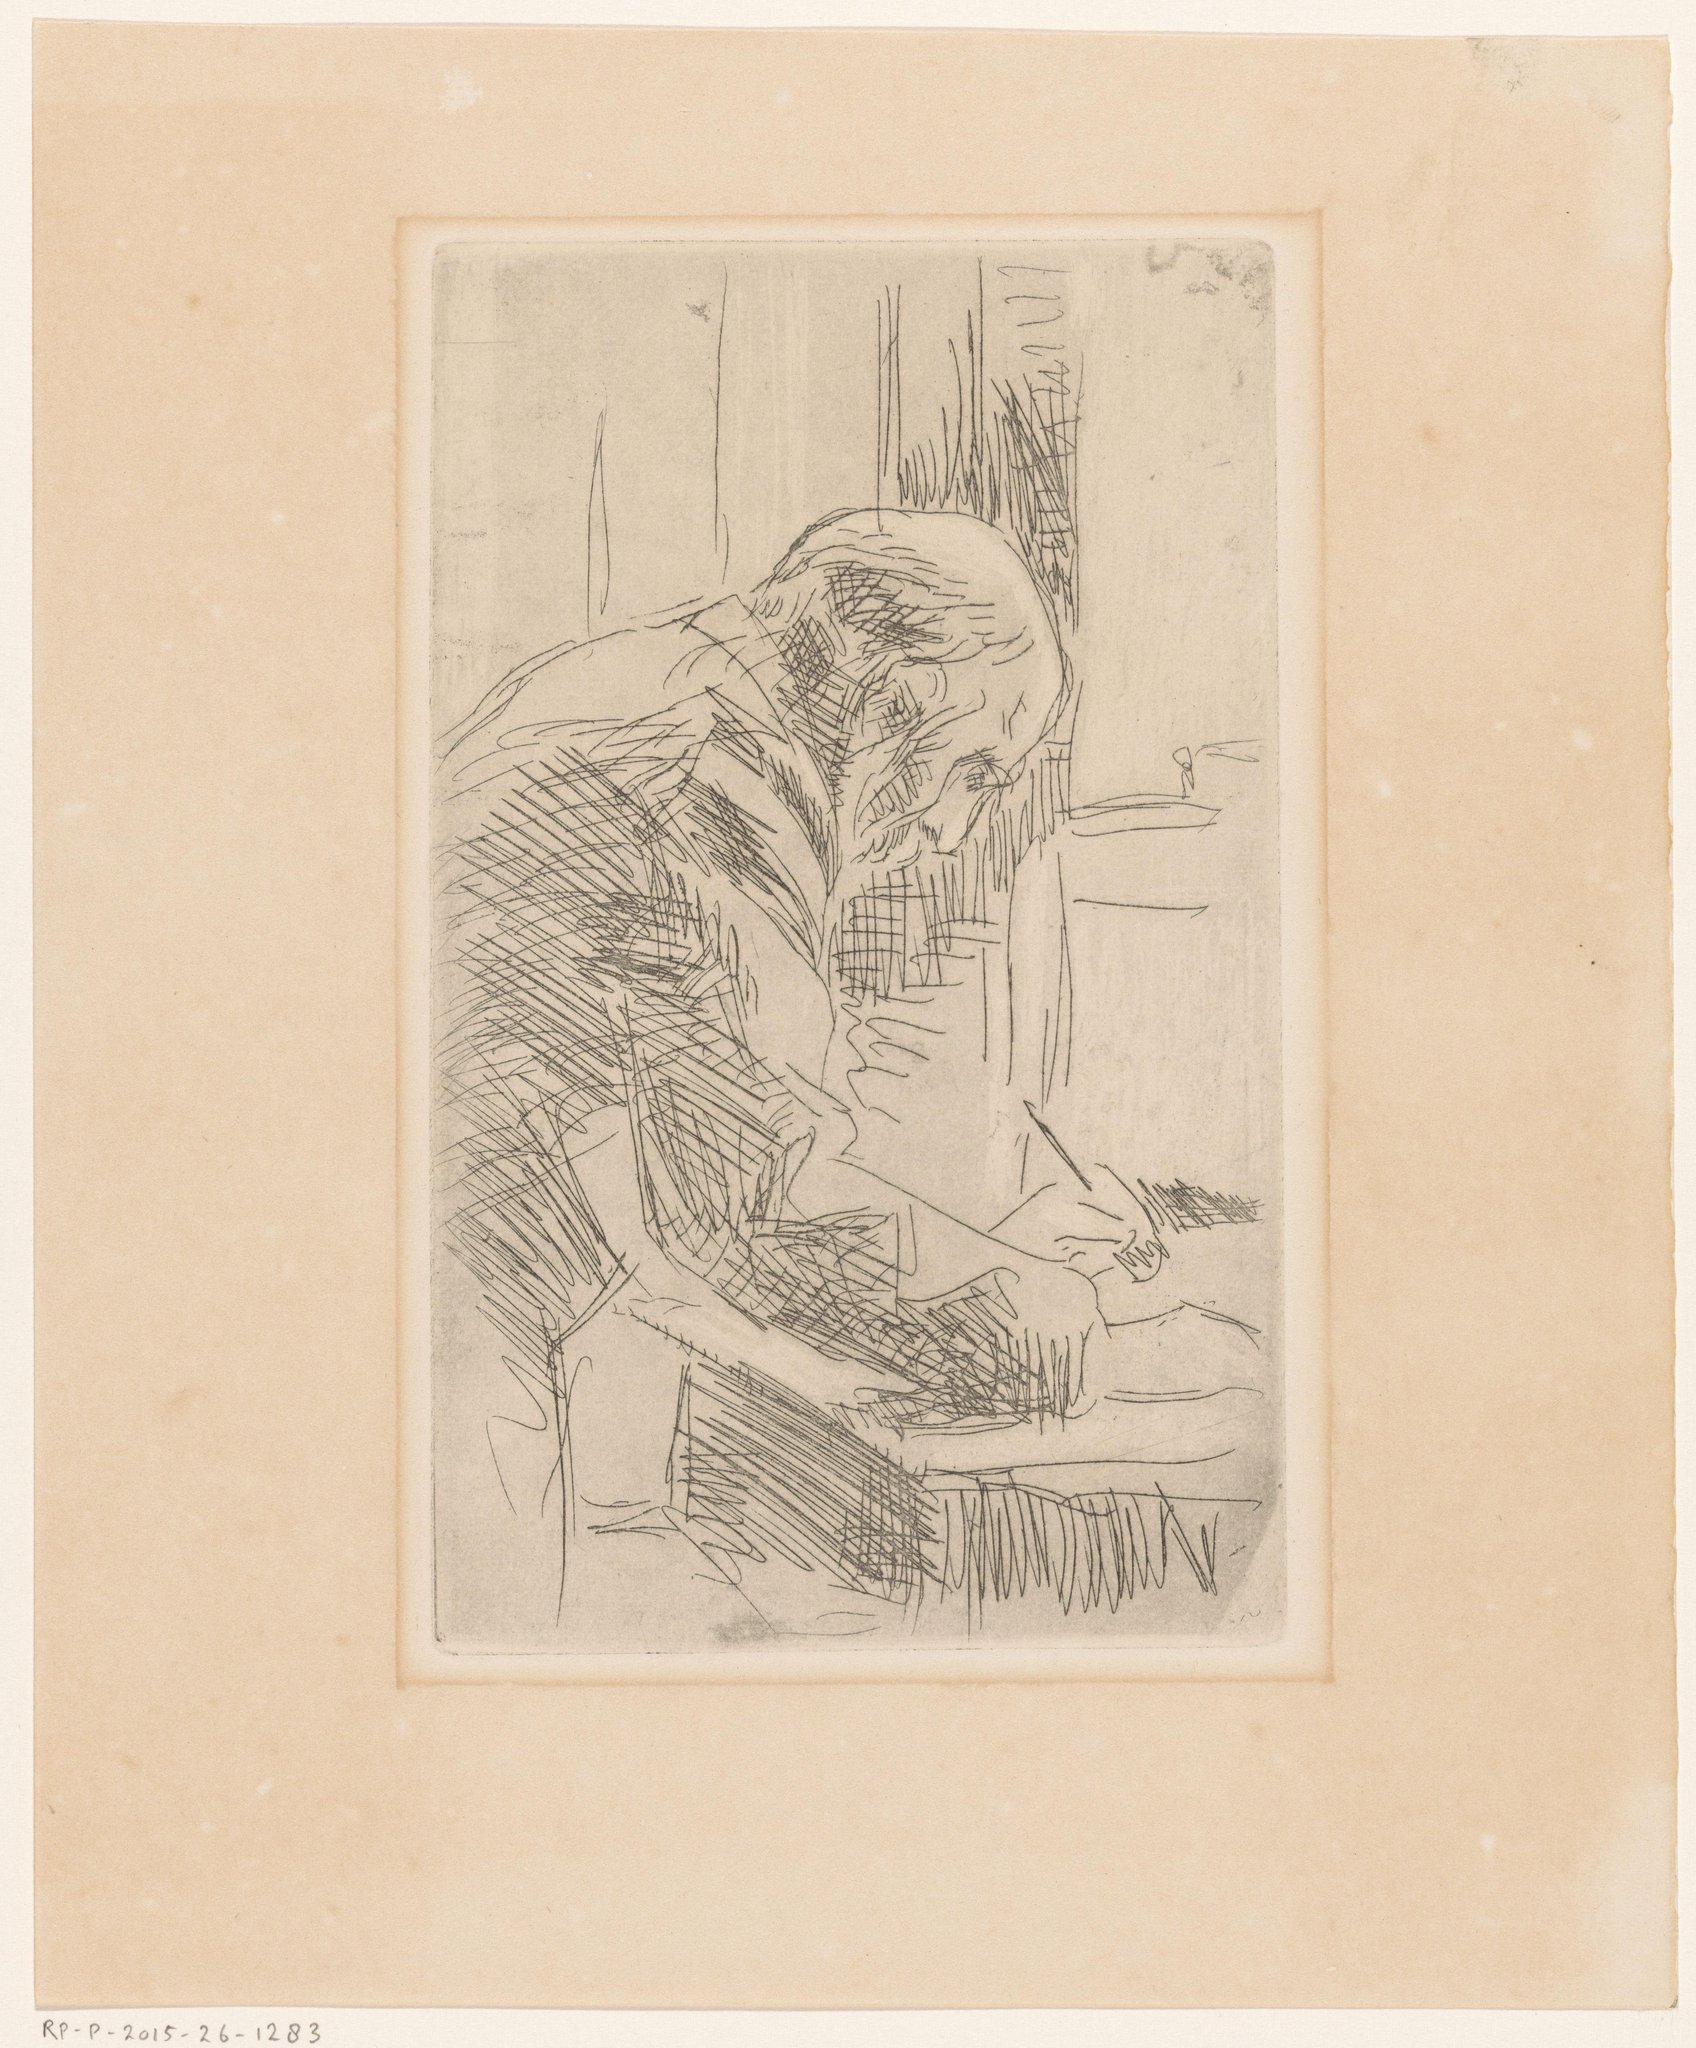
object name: print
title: Schrijvende man achter een bureau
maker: Anonymous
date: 1875-1925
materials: paper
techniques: etching, intaglio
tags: writing-table, writing-desk, handwriting, writing as activity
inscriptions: collector's mark: Lugt 2228